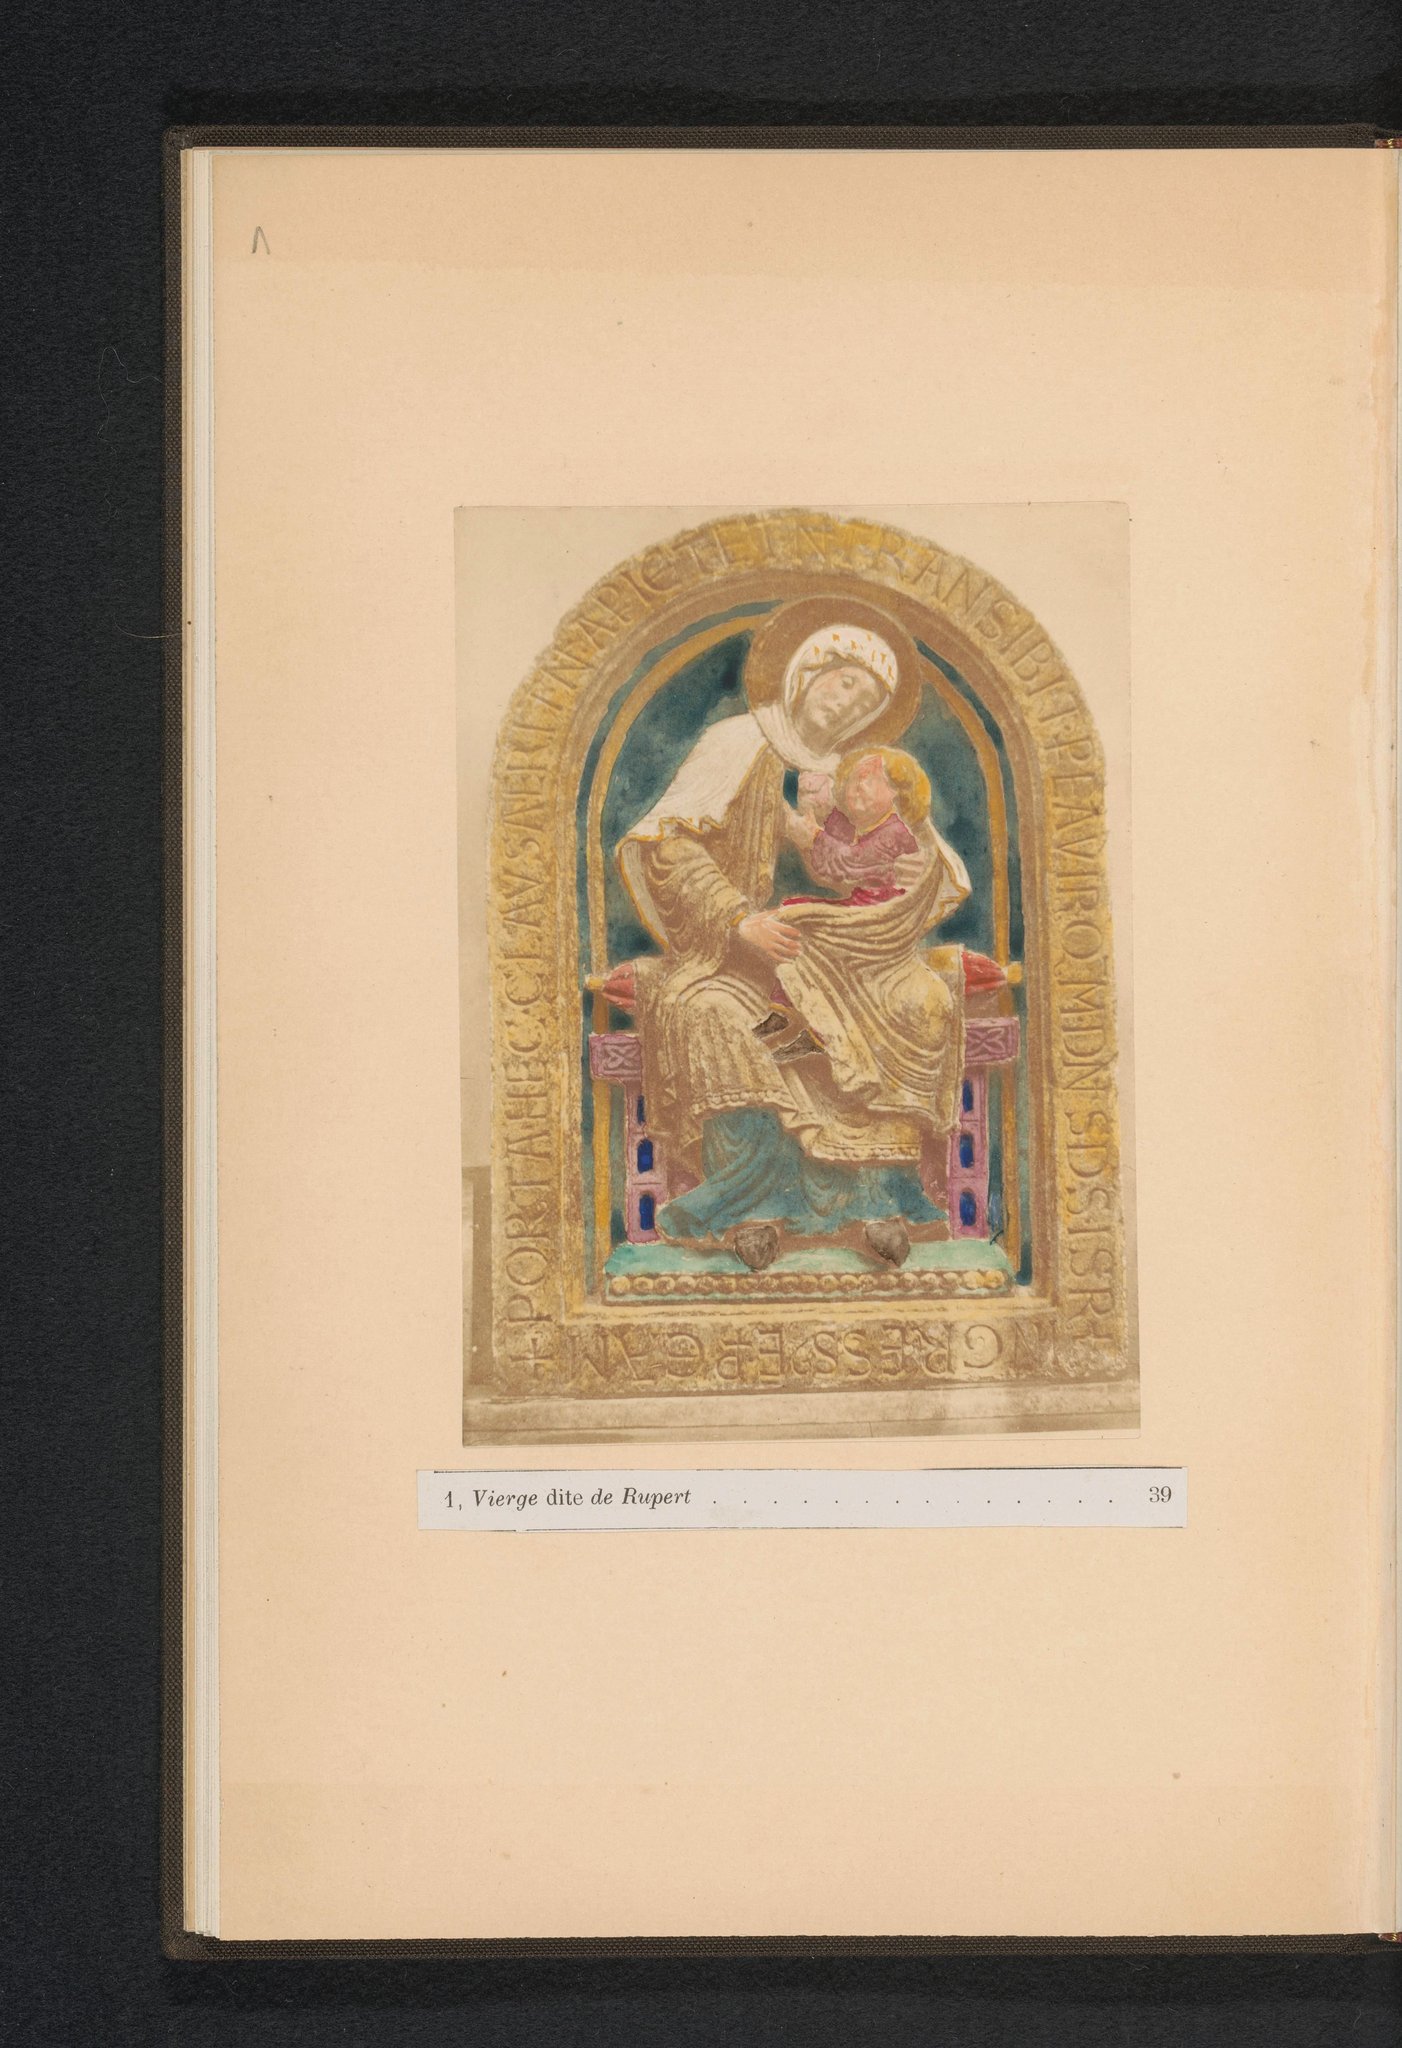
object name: page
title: Reliëf van Maria met kind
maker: Anonymous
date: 1877-1882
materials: photographic support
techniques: albumen print, hand coloring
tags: madonna: i.e. mary with the christ-child, sculpture (+ relief ~ sculpture)